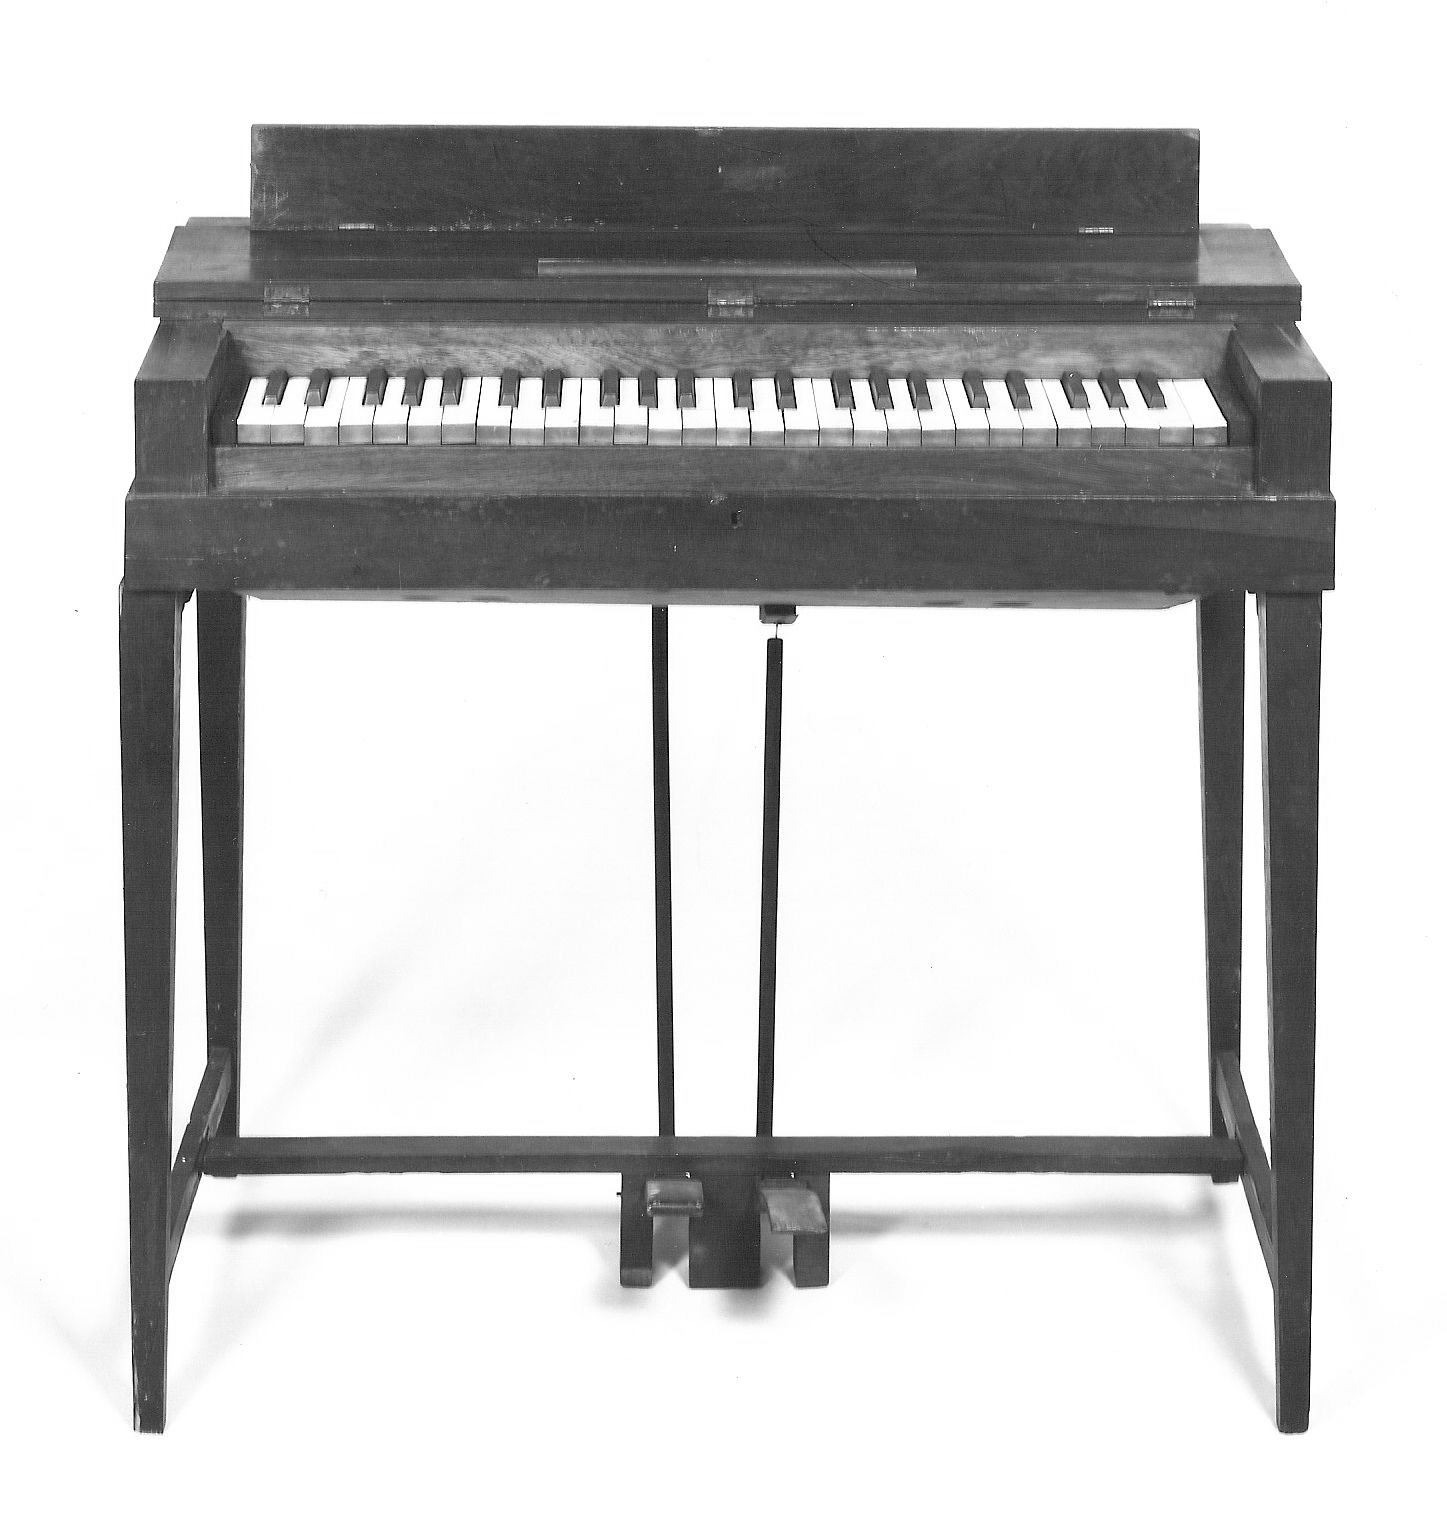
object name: seraphine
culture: american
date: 1840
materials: wood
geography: united states